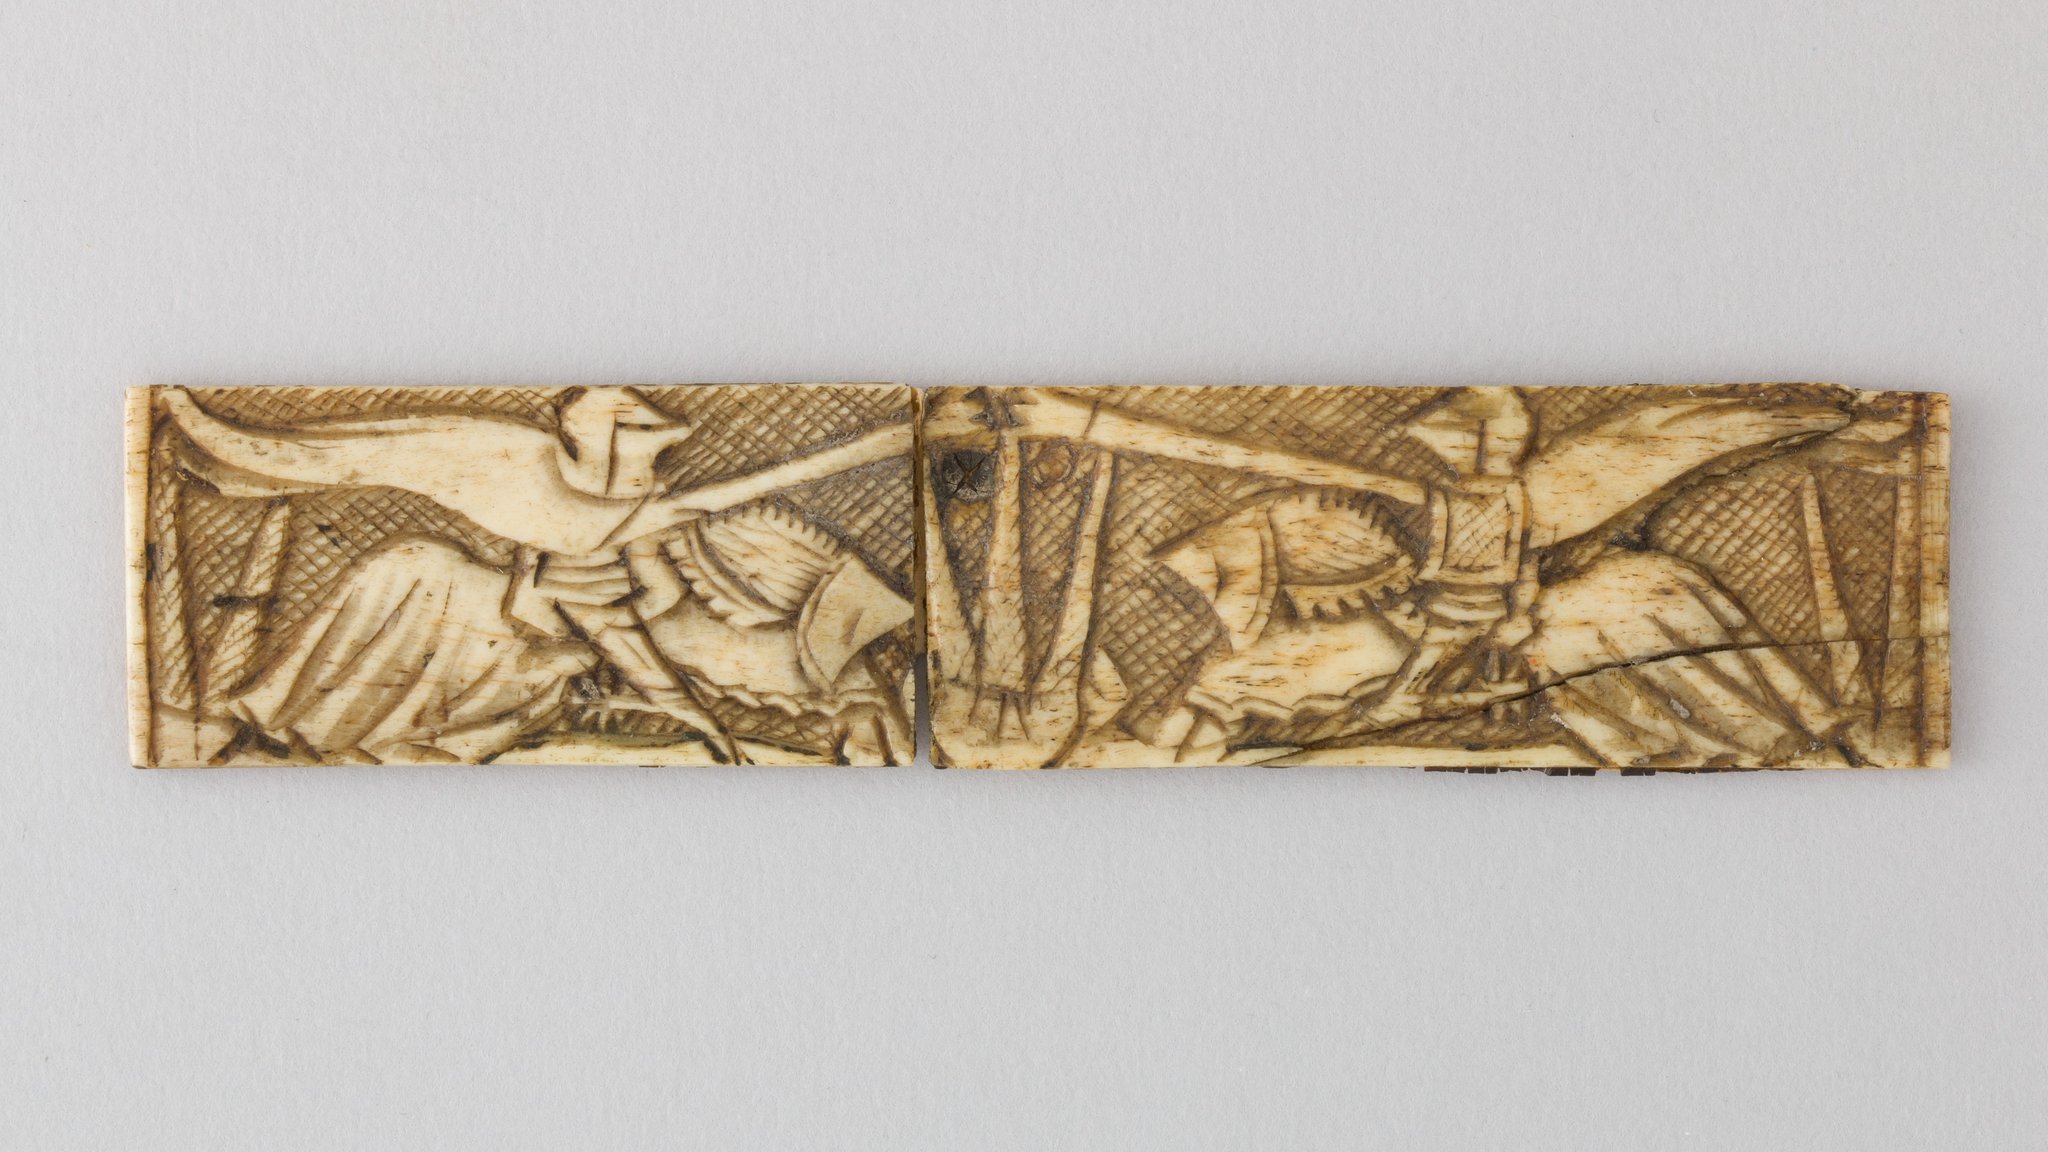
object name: plaque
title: Plaque with Jousting Knights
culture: french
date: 1401-1500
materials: ivory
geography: france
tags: knights